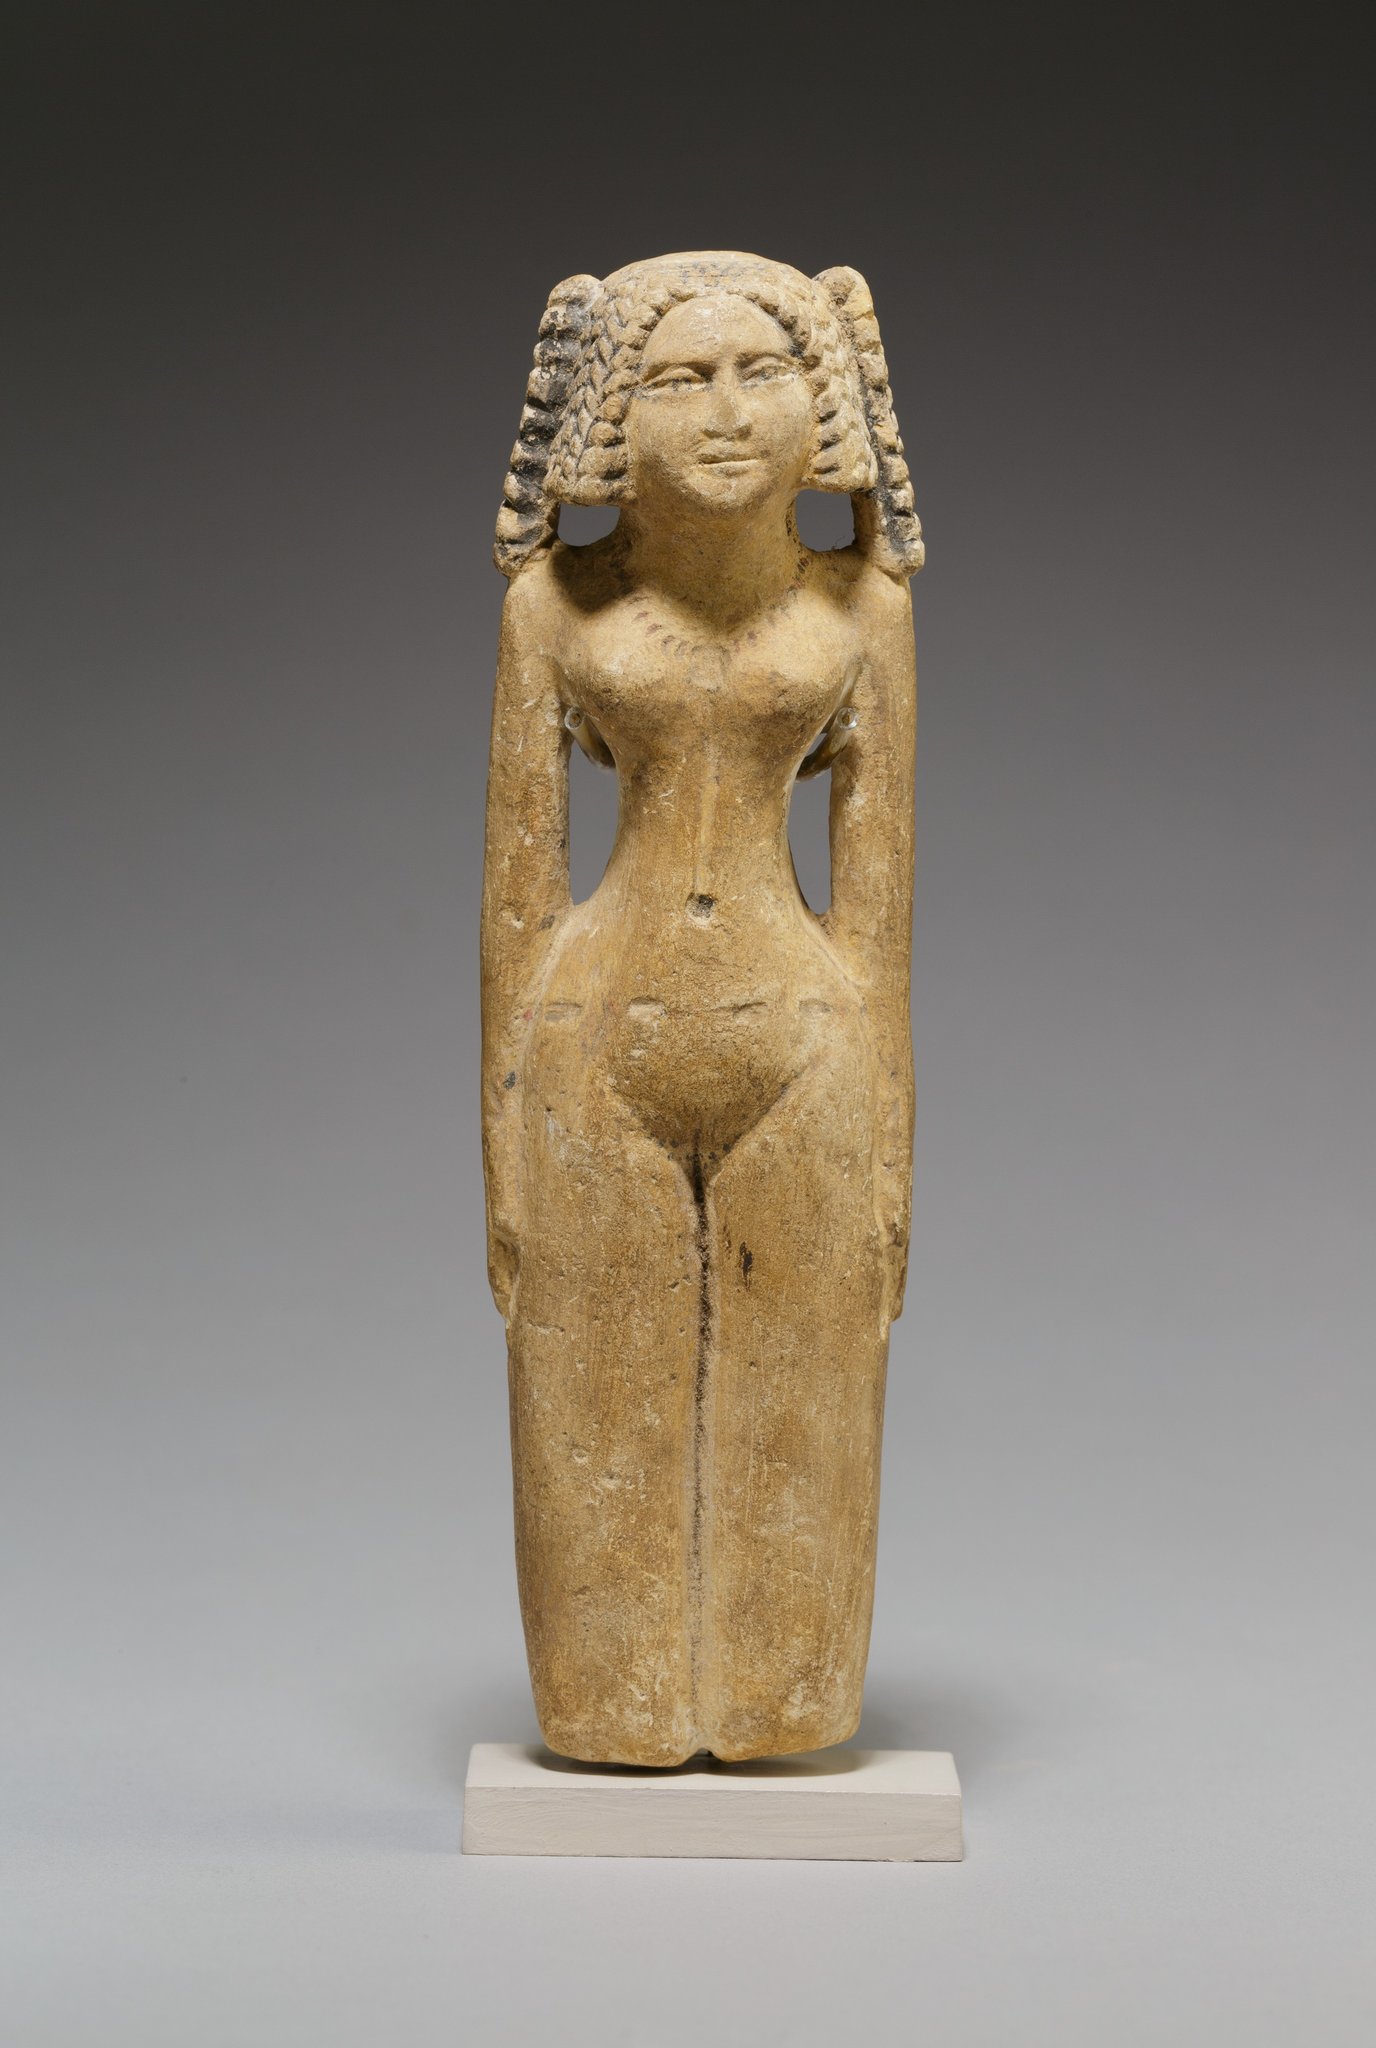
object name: statuette, female nude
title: Female figure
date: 1981-1550 BCE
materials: limestone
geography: egypt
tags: female nudes